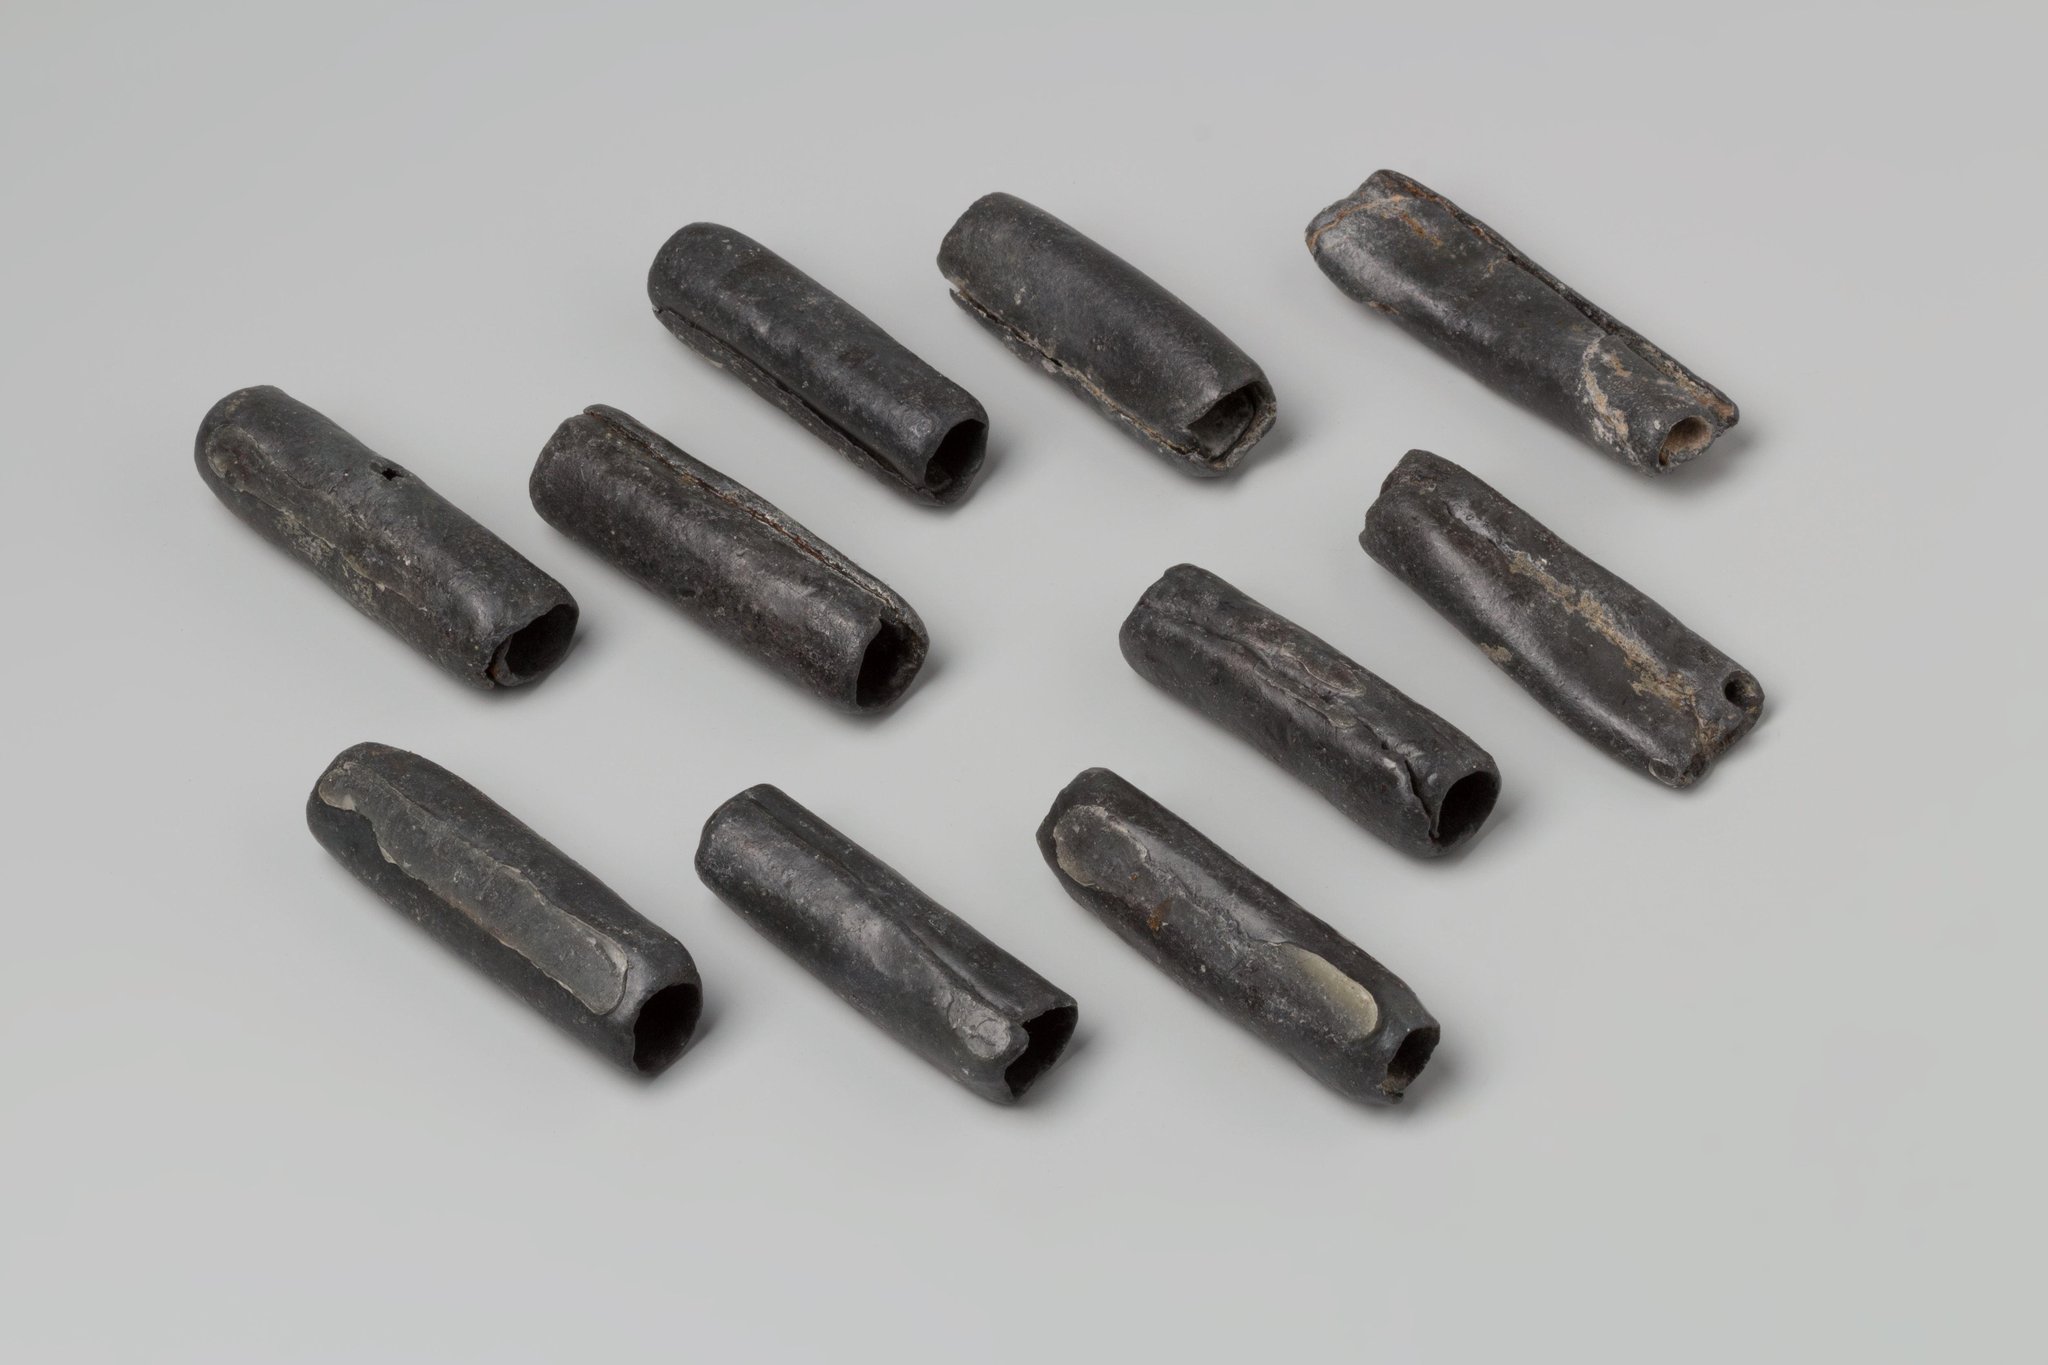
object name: lead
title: Loden rol uit het wrak van de Oost-Indiëvaarder 't Vliegend Hart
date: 1700-1735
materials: lead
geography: middelburg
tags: 't vliegend hart (schip), verenigde oostindische compagnie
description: Deze loden buisjes zijn vermoedelijk afkomstig van visnetten ofwel op TVliegend Hart zelf ofwel van vissers die hun netten aan het wrak verloren.